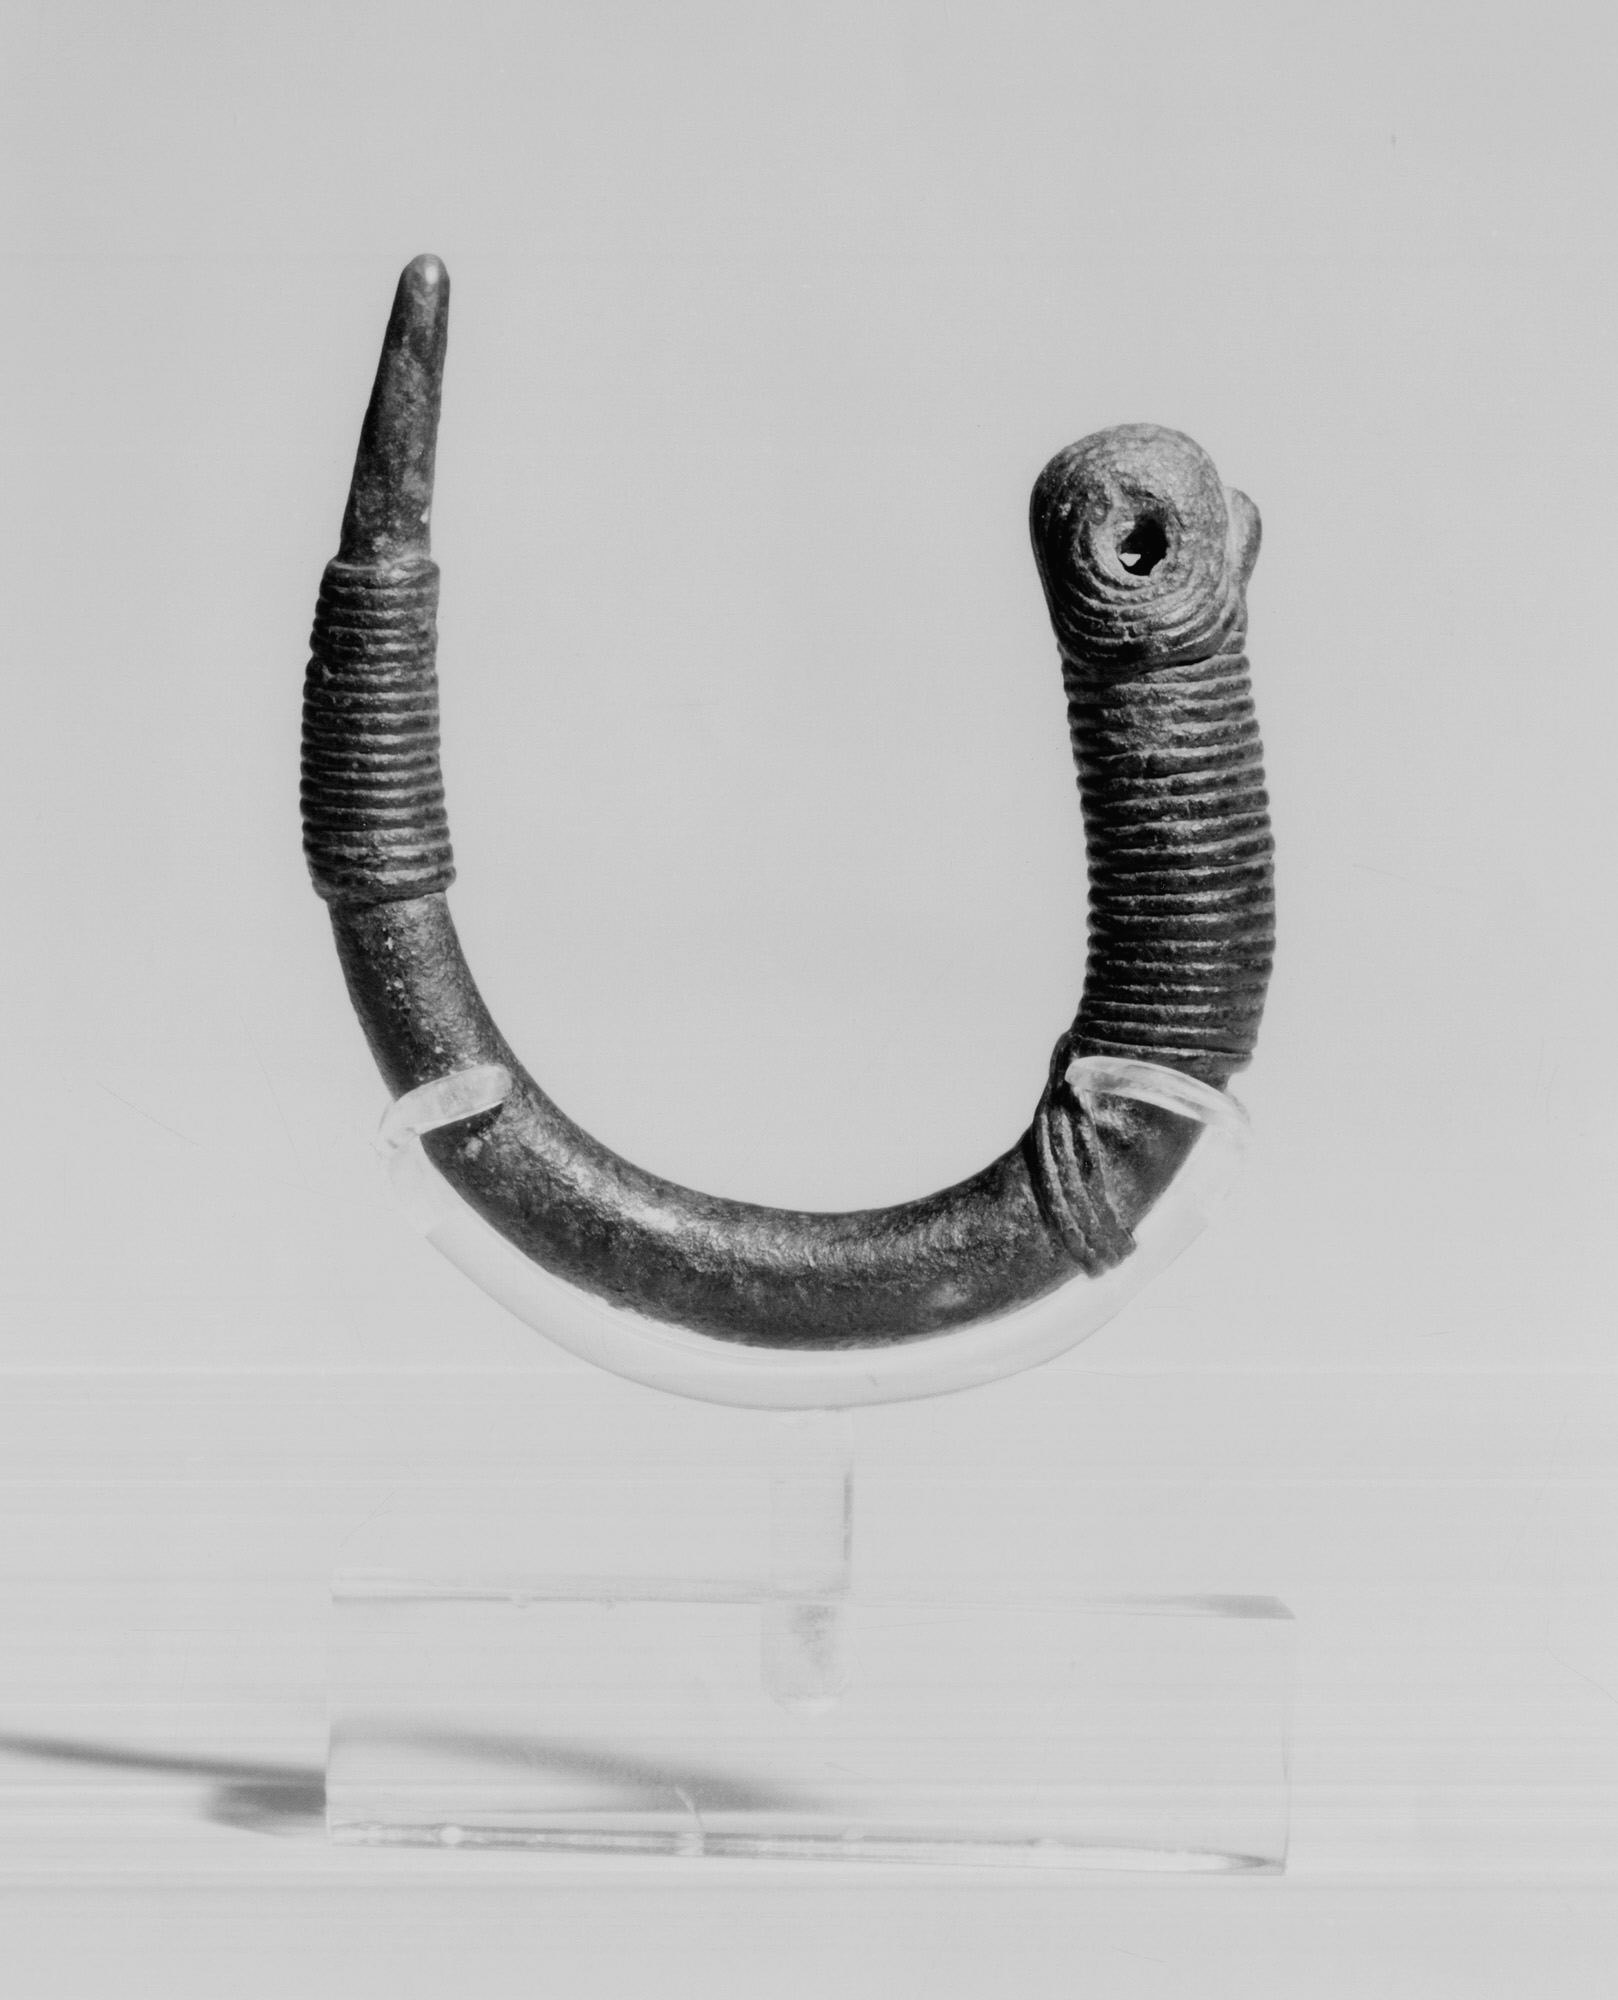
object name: hook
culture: thai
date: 500 BCE-300 CE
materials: bronze